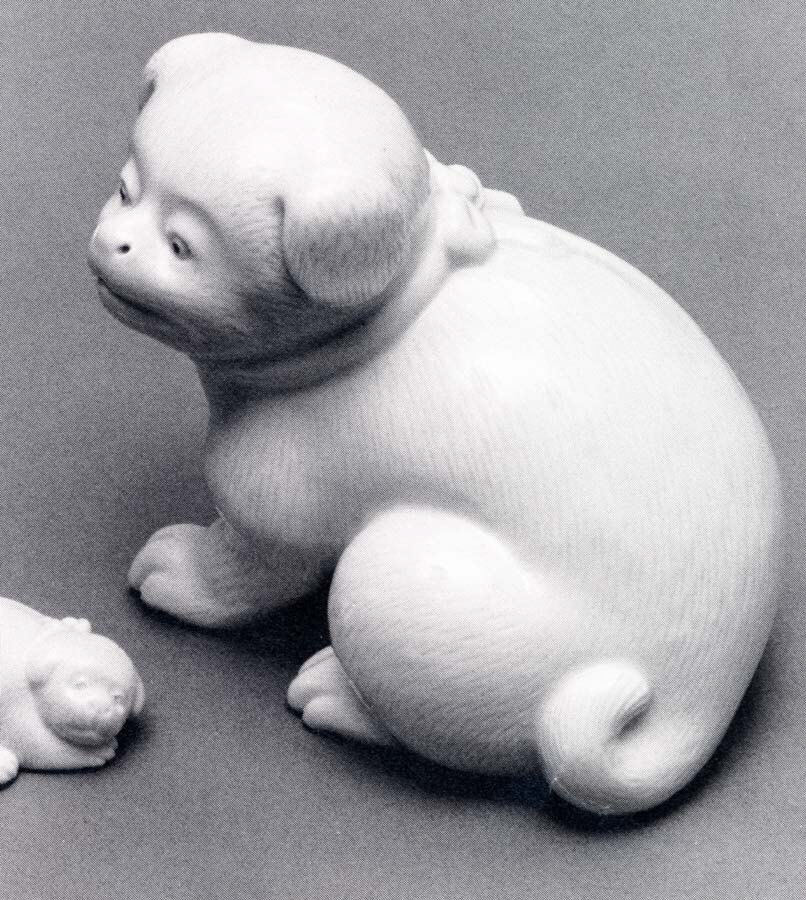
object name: puppy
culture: japanese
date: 1850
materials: porcelain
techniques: incising, molding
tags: dogs